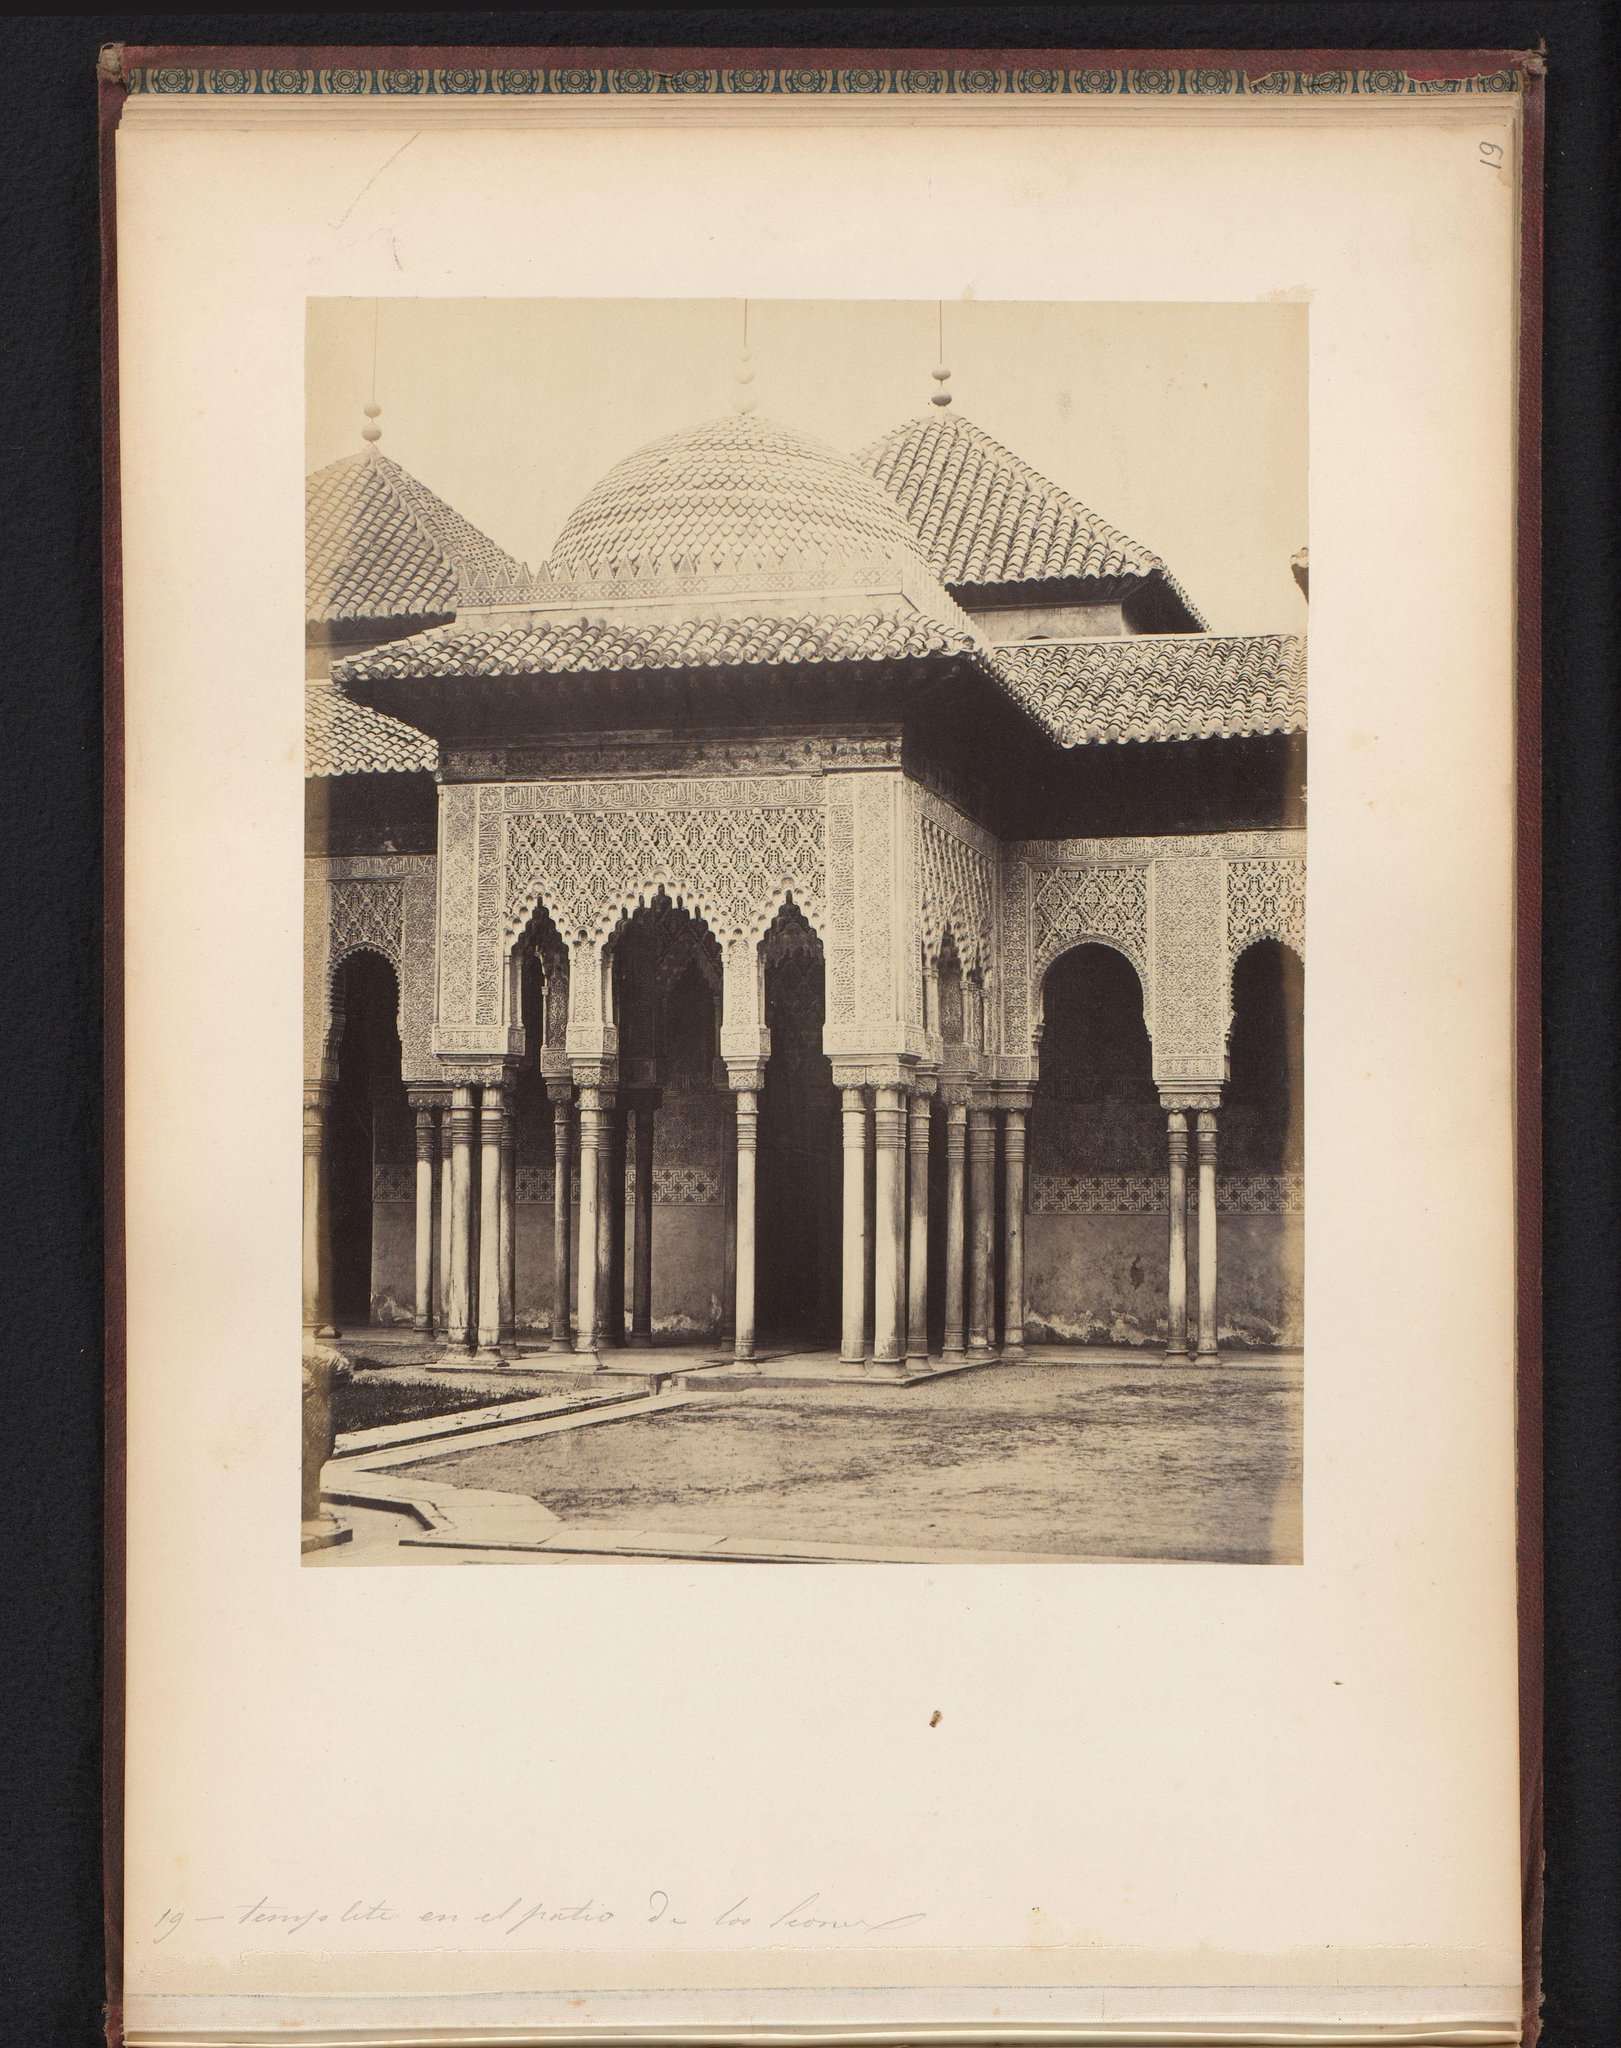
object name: photograph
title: Tempo lite en el Patio de los Leones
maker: c maufsaise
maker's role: fotograaf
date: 1906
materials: paper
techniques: albumen print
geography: granada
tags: palace, courtyard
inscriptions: number: ‘19’